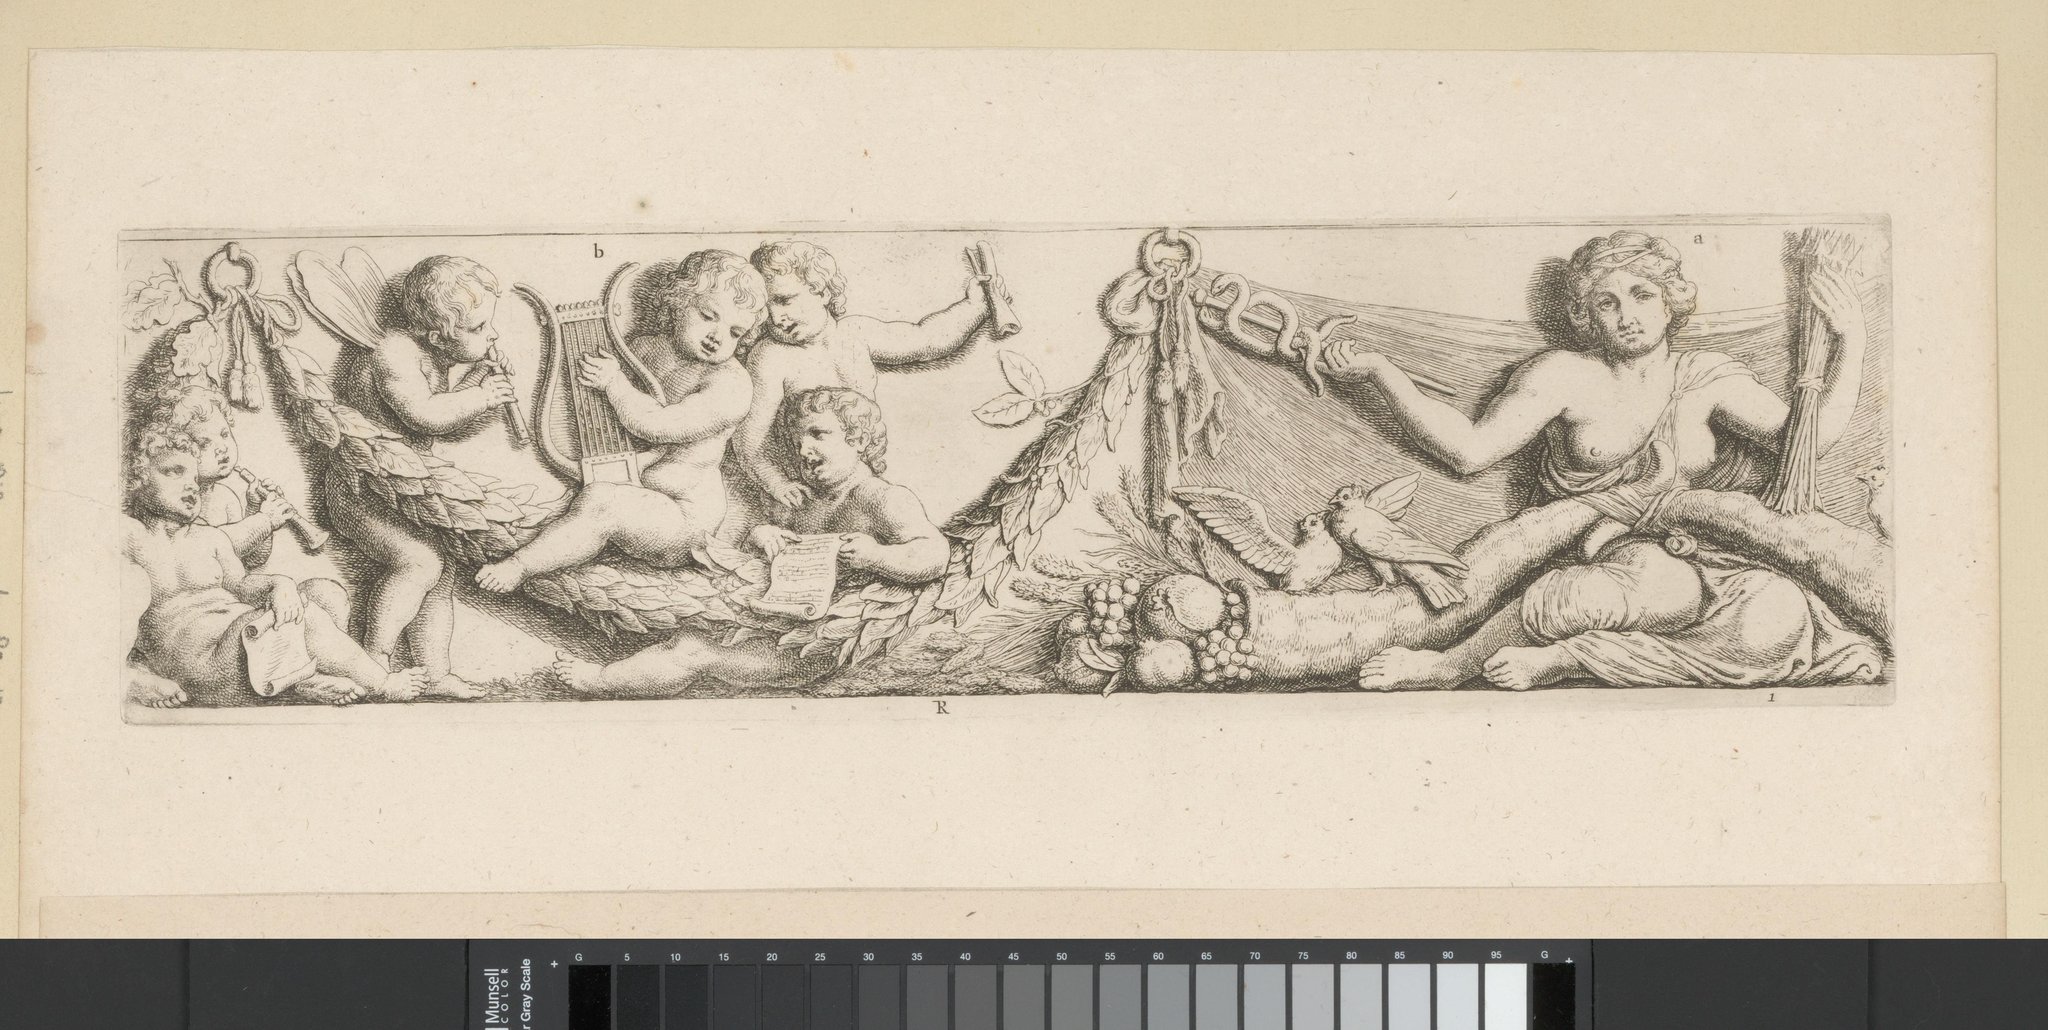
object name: print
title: Deel van fries op schouw in Vroedschapskamer van het Stadhuis op de Dam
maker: hubert quellinus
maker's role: print maker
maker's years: 1619-1687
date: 1663-1668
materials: paper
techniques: engraving, etching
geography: amsterdam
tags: musical instruments; group of musical instruments, 'cornucopia', horn of plenty, strife between virtues and vices, psychomachy, townhall, allegory, personification of good government, cupids: 'amores', 'amoretti', 'putti'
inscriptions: collector's mark: ‘16,85’ Lugt 1641b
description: Prent gebruikt in: Secunca pars Praecipuarum effigierum ac ornamentorum amplissime Curiae Amstelrodamensis maiori ex parte in cadido marmore effectorum per Artum Quellinium eiusdem Civitatis Statuarium / Het tweede deel Van de voornaemste Statuen ende Cieraten van 't konst-rijcke Stadt-huys van Amstelredam 'tmeeste in Marmer gemaeckt door Artus Quellinus Beelthouwer der voorseyde Stadt. Amsterdam: Artus Quellinus (I), 1663. Zie RP-P-AO-22-2-1 voor bijhorende titelpagina. Zie RP-P-AO-22-2-2 voor bijhorend register. Zie RP-P-AO-22-2A, RP-P-AO-22-2B, RP-P-AO-22-2C-1, RP-P-AO-22-2C-2, RP-P-AO-22-2C-3, RP-P-AO-22-2C-4, RP-P-AO-22-2D-1, RP-P-AO-22-2D-2, RP-P-AO-22-2D-3, RP-P-AO-22-2E-1, RP-P-AO-22-2E-2, RP-P-AO-22-2E-3, RP-P-AO-22-2E-4, RP-P-AO-22-2F-1, RP-P-AO-22-2F-2, RP-P-AO-22-2F-3, RP-P-AO-22-2G, RP-P-AO-22-2H, RP-P-AO-22-2I, RP-P-AO-22-2K, RP-P-AO-22-2L, RP-P-AO-22-2M, RP-P-AO-22-2N, RP-P-AO-22-2O-1, RP-P-AO-22-2O-2, RP-P-AO-22-2O-3, RP-P-AO-22-2O-4, RP-P-AO-22-2O-5, RP-P-AO-22-2O-6, RP-P-AO-22-2O-7, RP-P-AO-22-2P-1, RP-P-AO-22-2P-2, RP-P-AO-22-2Q-1, RP-P-AO-22-2Q-2, RP-P-AO-22-2Q-3, RP-P-AO-22-2R-2, RP-P-AO-22-2R-3, RP-P-AO-22-2S, RP-P-AO-22-2T-1, RP-P-AO-22-2T-2, RP-P-AO-22-2T-3, RP-P-AO-22-2T-4, RP-P-AO-22-2V-1, RP-P-AO-22-2V-2, RP-P-AO-22-2W-1, RP-P-AO-22-2W-2, RP-P-AO-22-2X-1, RP-P-AO-22-2X-2 en RP-P-AO-22-2X-3 voor andere prenten uit deze publicatie. Zelfde staat van prent ook gebruikt in: Secunca pars Praecipuarum effigierum ac ornamentorum amplissime Curiae Amstelrodamensis maiori ex parte in cadido marmore effectorum per Artum Quellinium eiusdem Civitatis Statuarium / Het tweede deel Van de voornaemste Statuen ende Cieraten van 't konst-rijcke Stadt-huys van Amstelredam 'tmeeste in Marmer gemaeckt door Artus Quellinus Beelthouwer der voorseyde Stadt. Amsterdam: Frederik de Wit, 1668. Latere staat van prent ook gebruikt in: Architecture peinture et sculpture de la Maison de Ville d'Amsterdam, representee en CIX. figures en taille-douce (…). Amsterdam: David Mortier, 1719. En in: Architecture peinture et sculpture de la Maison de Ville d'Amsterdam, representee en CIX. figures en taille-douce (…). Amsterdam: Gerard Valck, 1719. En in: Bouw schilder en beeldhouwkonst, van het Stadhuis te Amsteldam, vertoont in CIX figuuren (…). Amsterdam: Covens & Mortier & Covens Jr., s.a. (1774-1783).